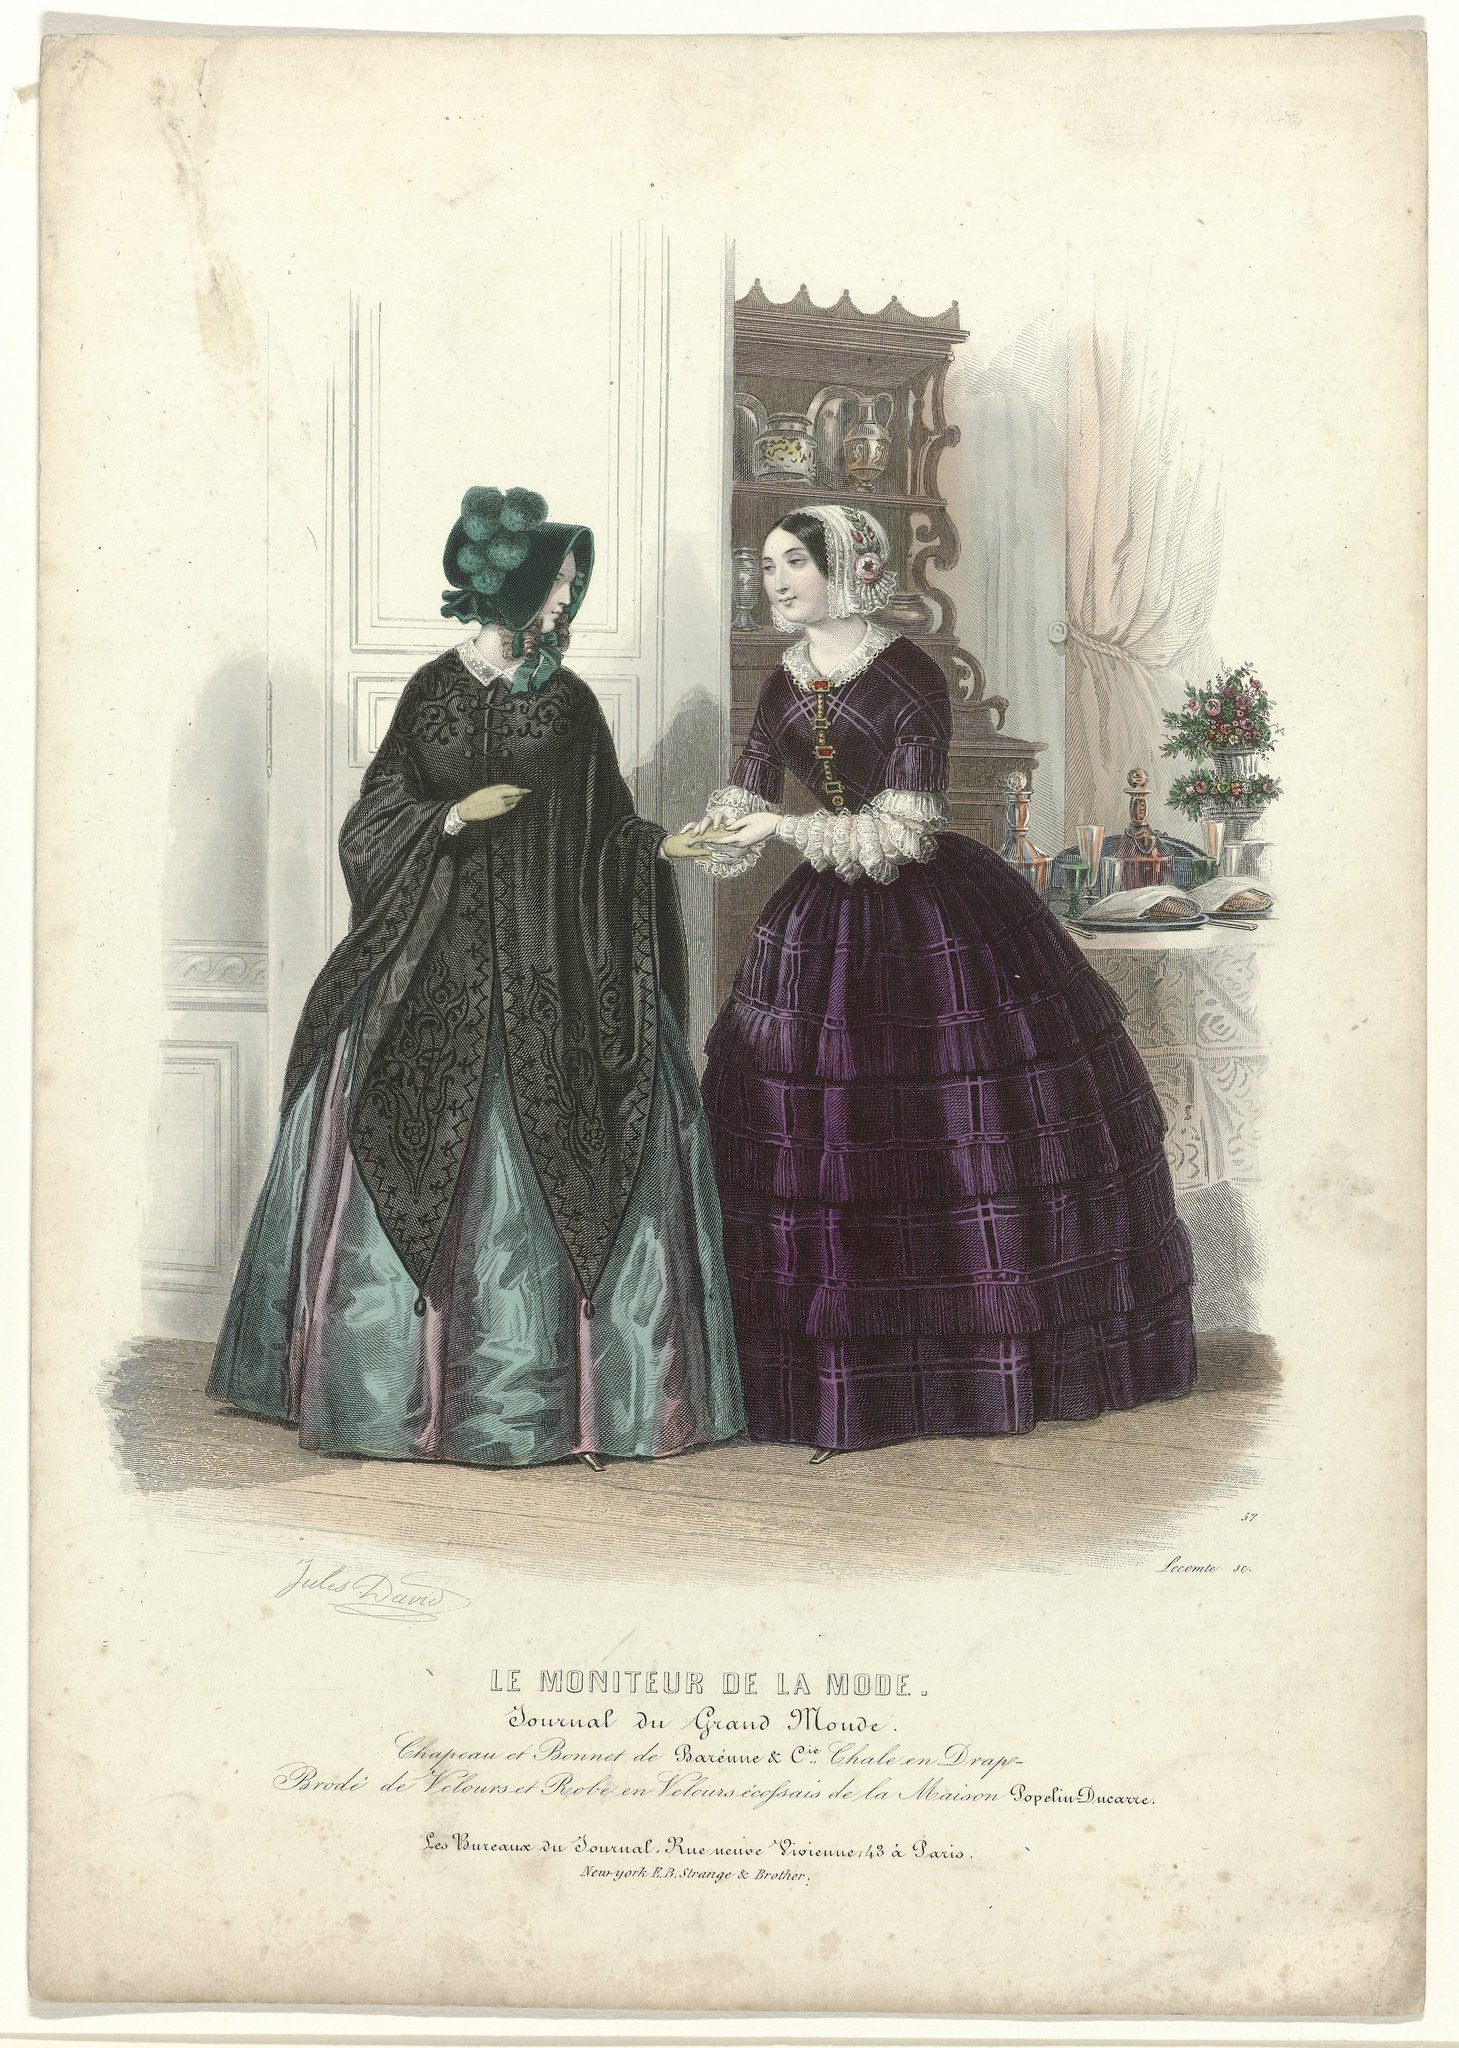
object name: fashion print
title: Le Moniteur de la Mode, 1844, No. 57 : Chapeau et Bonnet (...)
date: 1844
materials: paper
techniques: engraving, hand coloring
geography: paris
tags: clothing for the upper part of the body (shawl) (+ women's clothes), embroidery (ornamentation) (+ women's clothes), head-gear: cap (+ women's clothes), fashion plates, head-gear: hat (+ women's clothes), shoes, sandals (+ women's clothes), gloves, mittens, etc. (+ women's clothes), dress, gown (+ women's clothes), laid table: table-ware, table-decoration, etc.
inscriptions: caption: ‘Chapeau et Bonnet de Barénne & C"ie Chale en Drap- Brodé de Velours et Robe en Velours écossais de la Maison Popelin-Ducarre.’, title: ‘Le Moniteur de la Mode. / Journal du Grand Monde.’, address: ‘Les Bureaux du Journal. Rue Neuve Vivienne, 43 à Paris . / New-york E.B. Strange & brother.’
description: Twee vrouwen in een interieur. Volgens het onderschrift: hoed en muts van Barénne & Cie. Sjaal van laken met borduurwerk in fluweel. Japon van geruite fluweel van Popelin Ducarre. Prent uit het modetijdschrift Le Moniteur de la Mode (1843-1913).